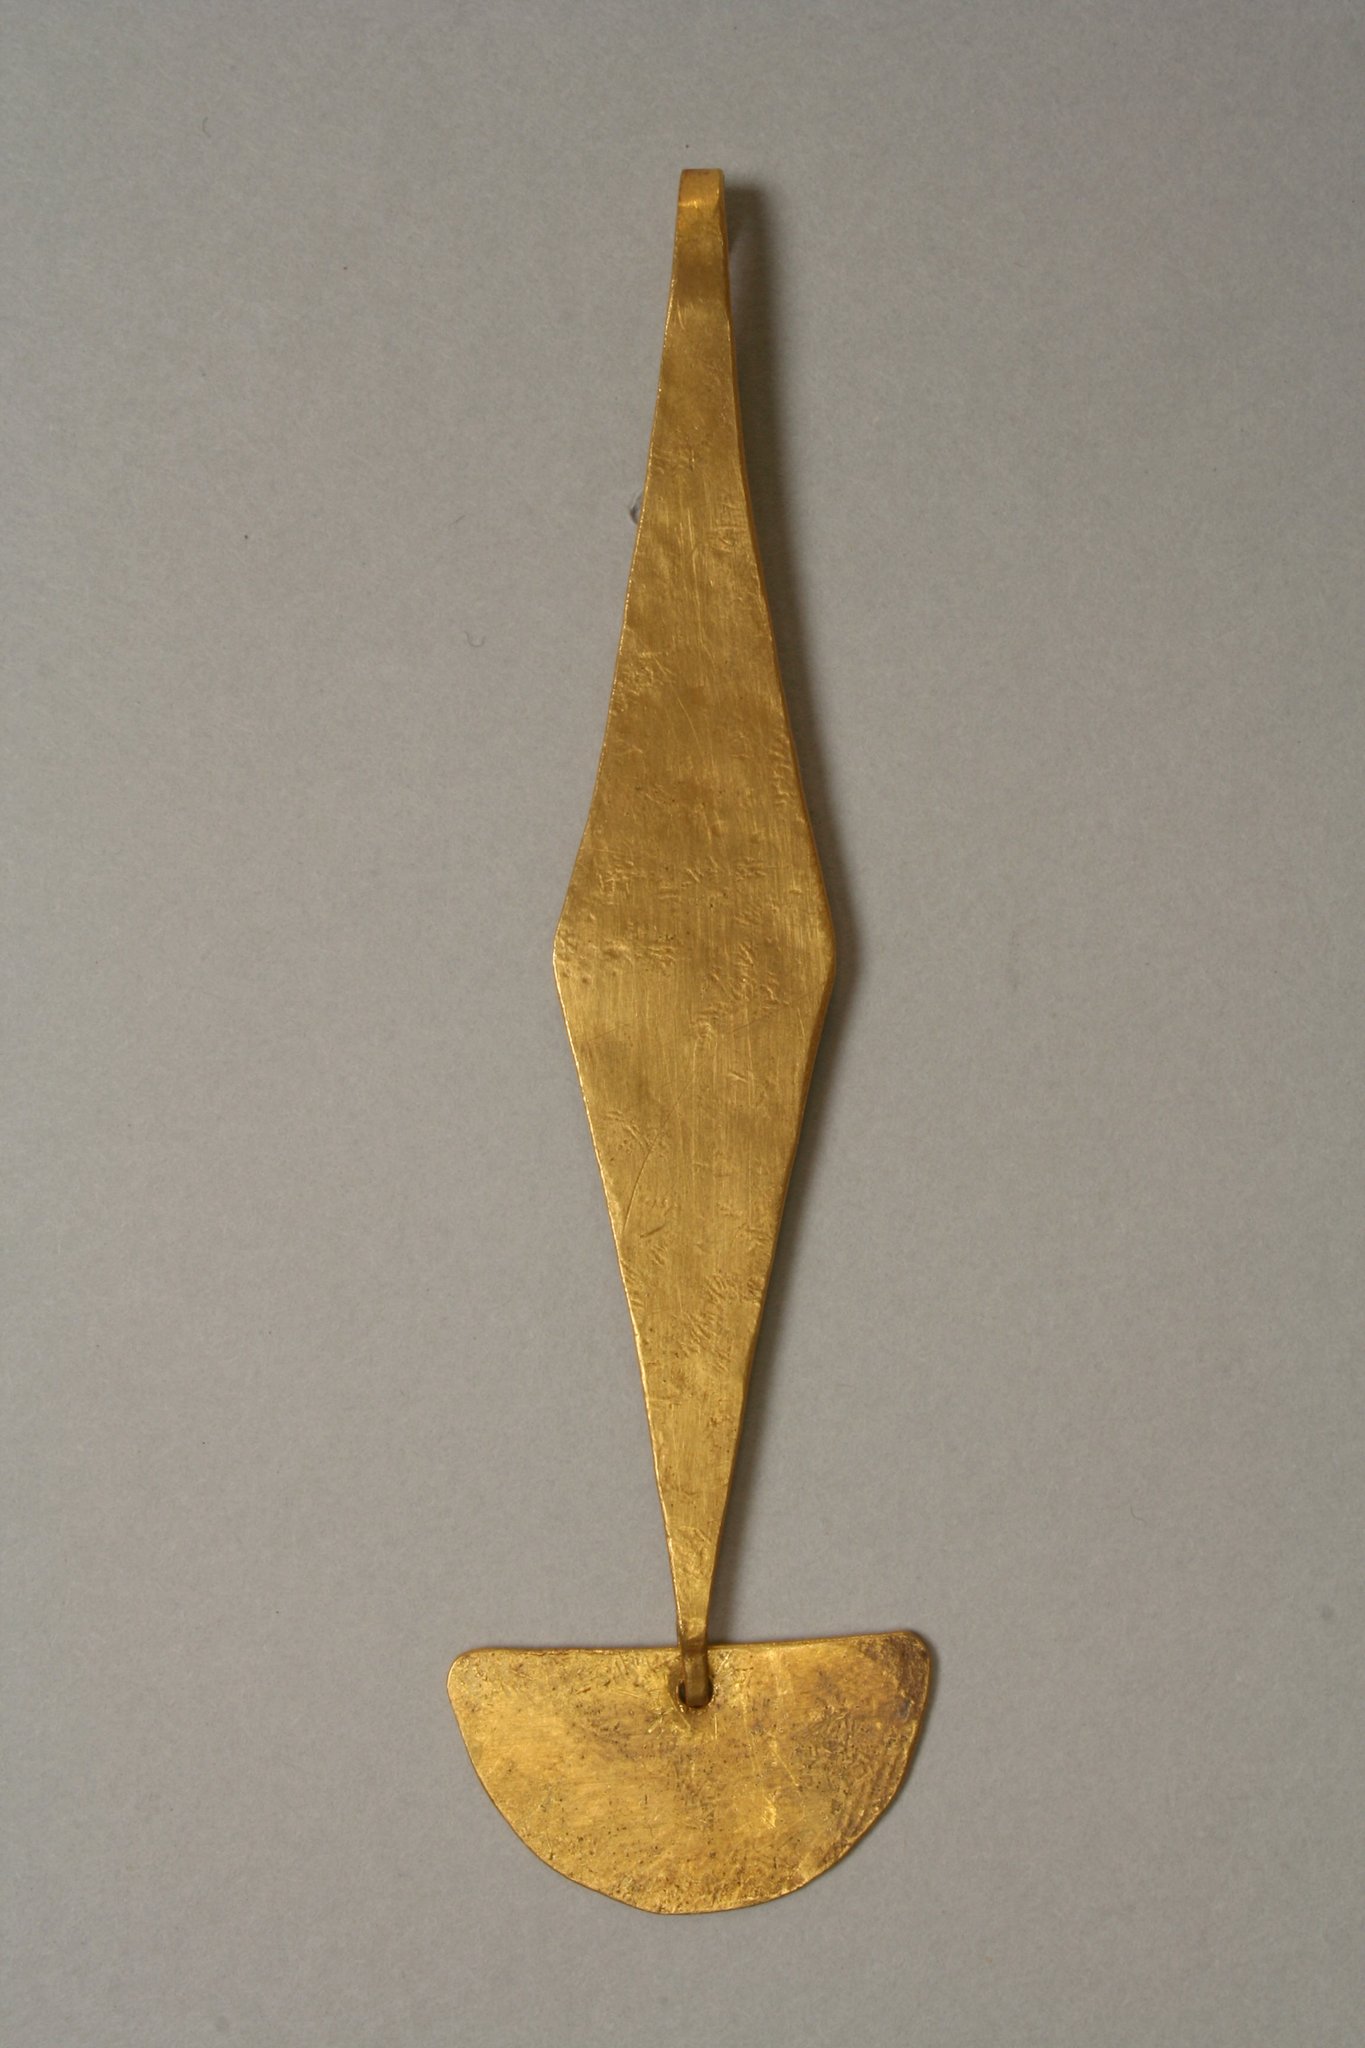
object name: ornament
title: Ear Ornament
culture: caldas or sonso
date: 801-1500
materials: gold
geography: colombia